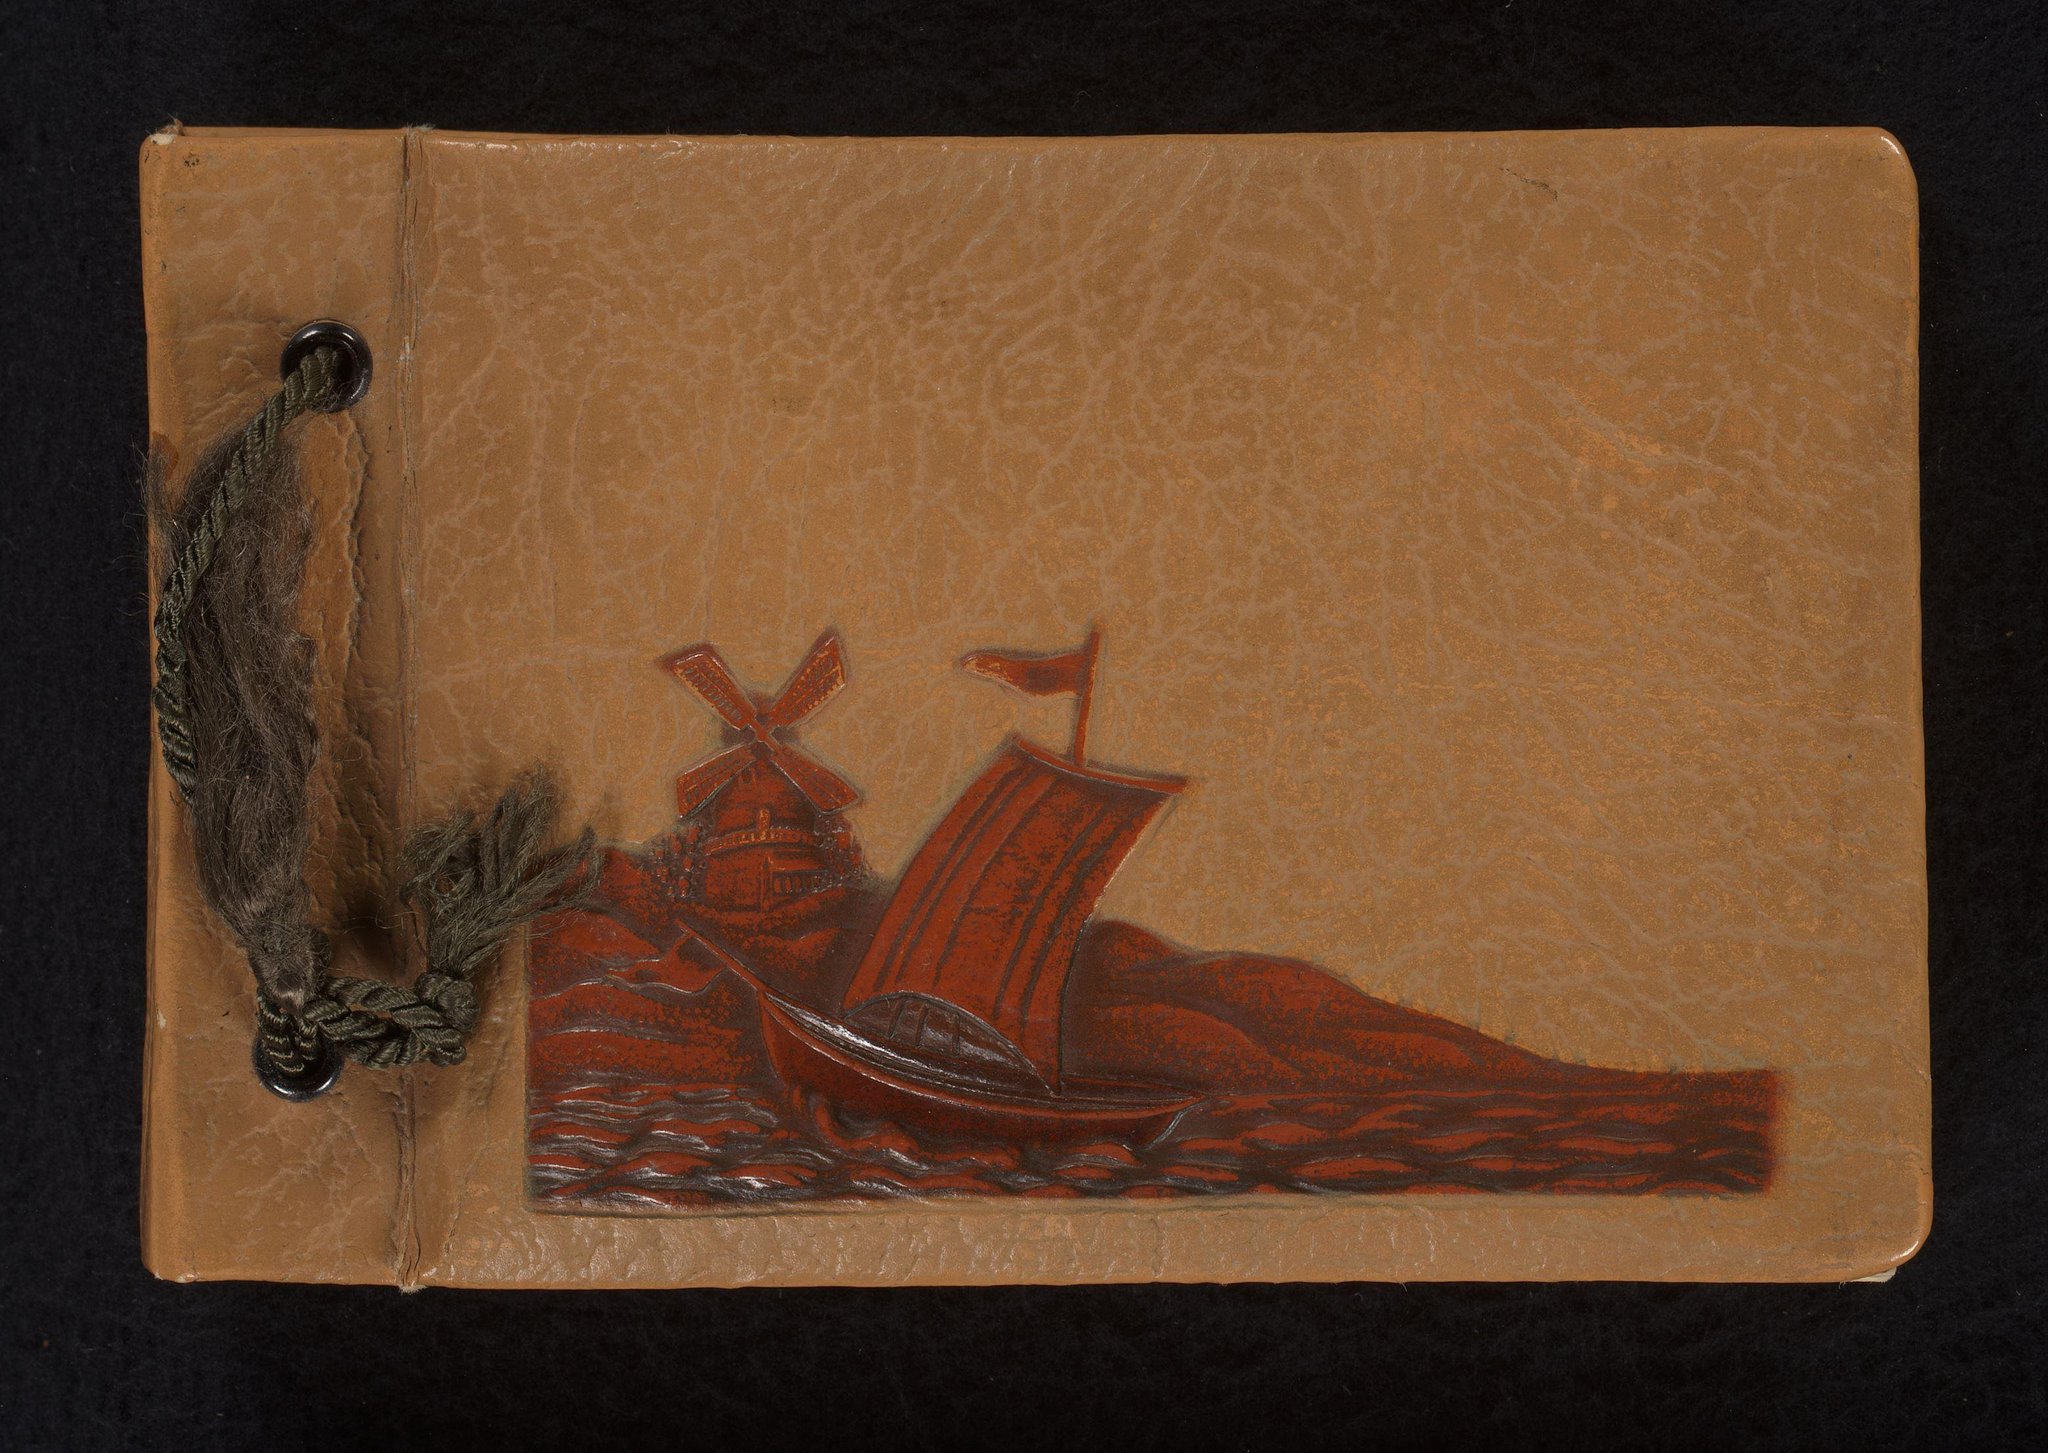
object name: photograph album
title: Fotoalbum Kriegsmarine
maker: Anonymous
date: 1940-1943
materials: leather, paper, photographic support, textile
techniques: gelatin silver print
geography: germany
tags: occupation ~ war, netherlands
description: Klein Duits militair fotoalbum uit de Tweede Wereldoorlog samengesteld door een militair van de Kriegsmarine. Omslag van beige kunstleer met een afbeelding van een scheepje op zee en een windmolen. Koordje door de rug. Binnenwerk bestaande uit 24 bladen met in totaal 49 foto's. Vensters van de bladen 42 en 43 zijn leeg. De meeste foto's gemaakt in Nederland, veelal op de Afsluitdijk. Het album toont verder het onderkomen van de Kriegsmarine (Dienststelle 23 443) en de matrozen die er verbleven, de matrozen aan boord van hun schip en verschillende Nederlandse visserschepen en binnenvaartuigen. Verder foto's van Nederlandse dorpen en steden, waaronder Leeuwarden.